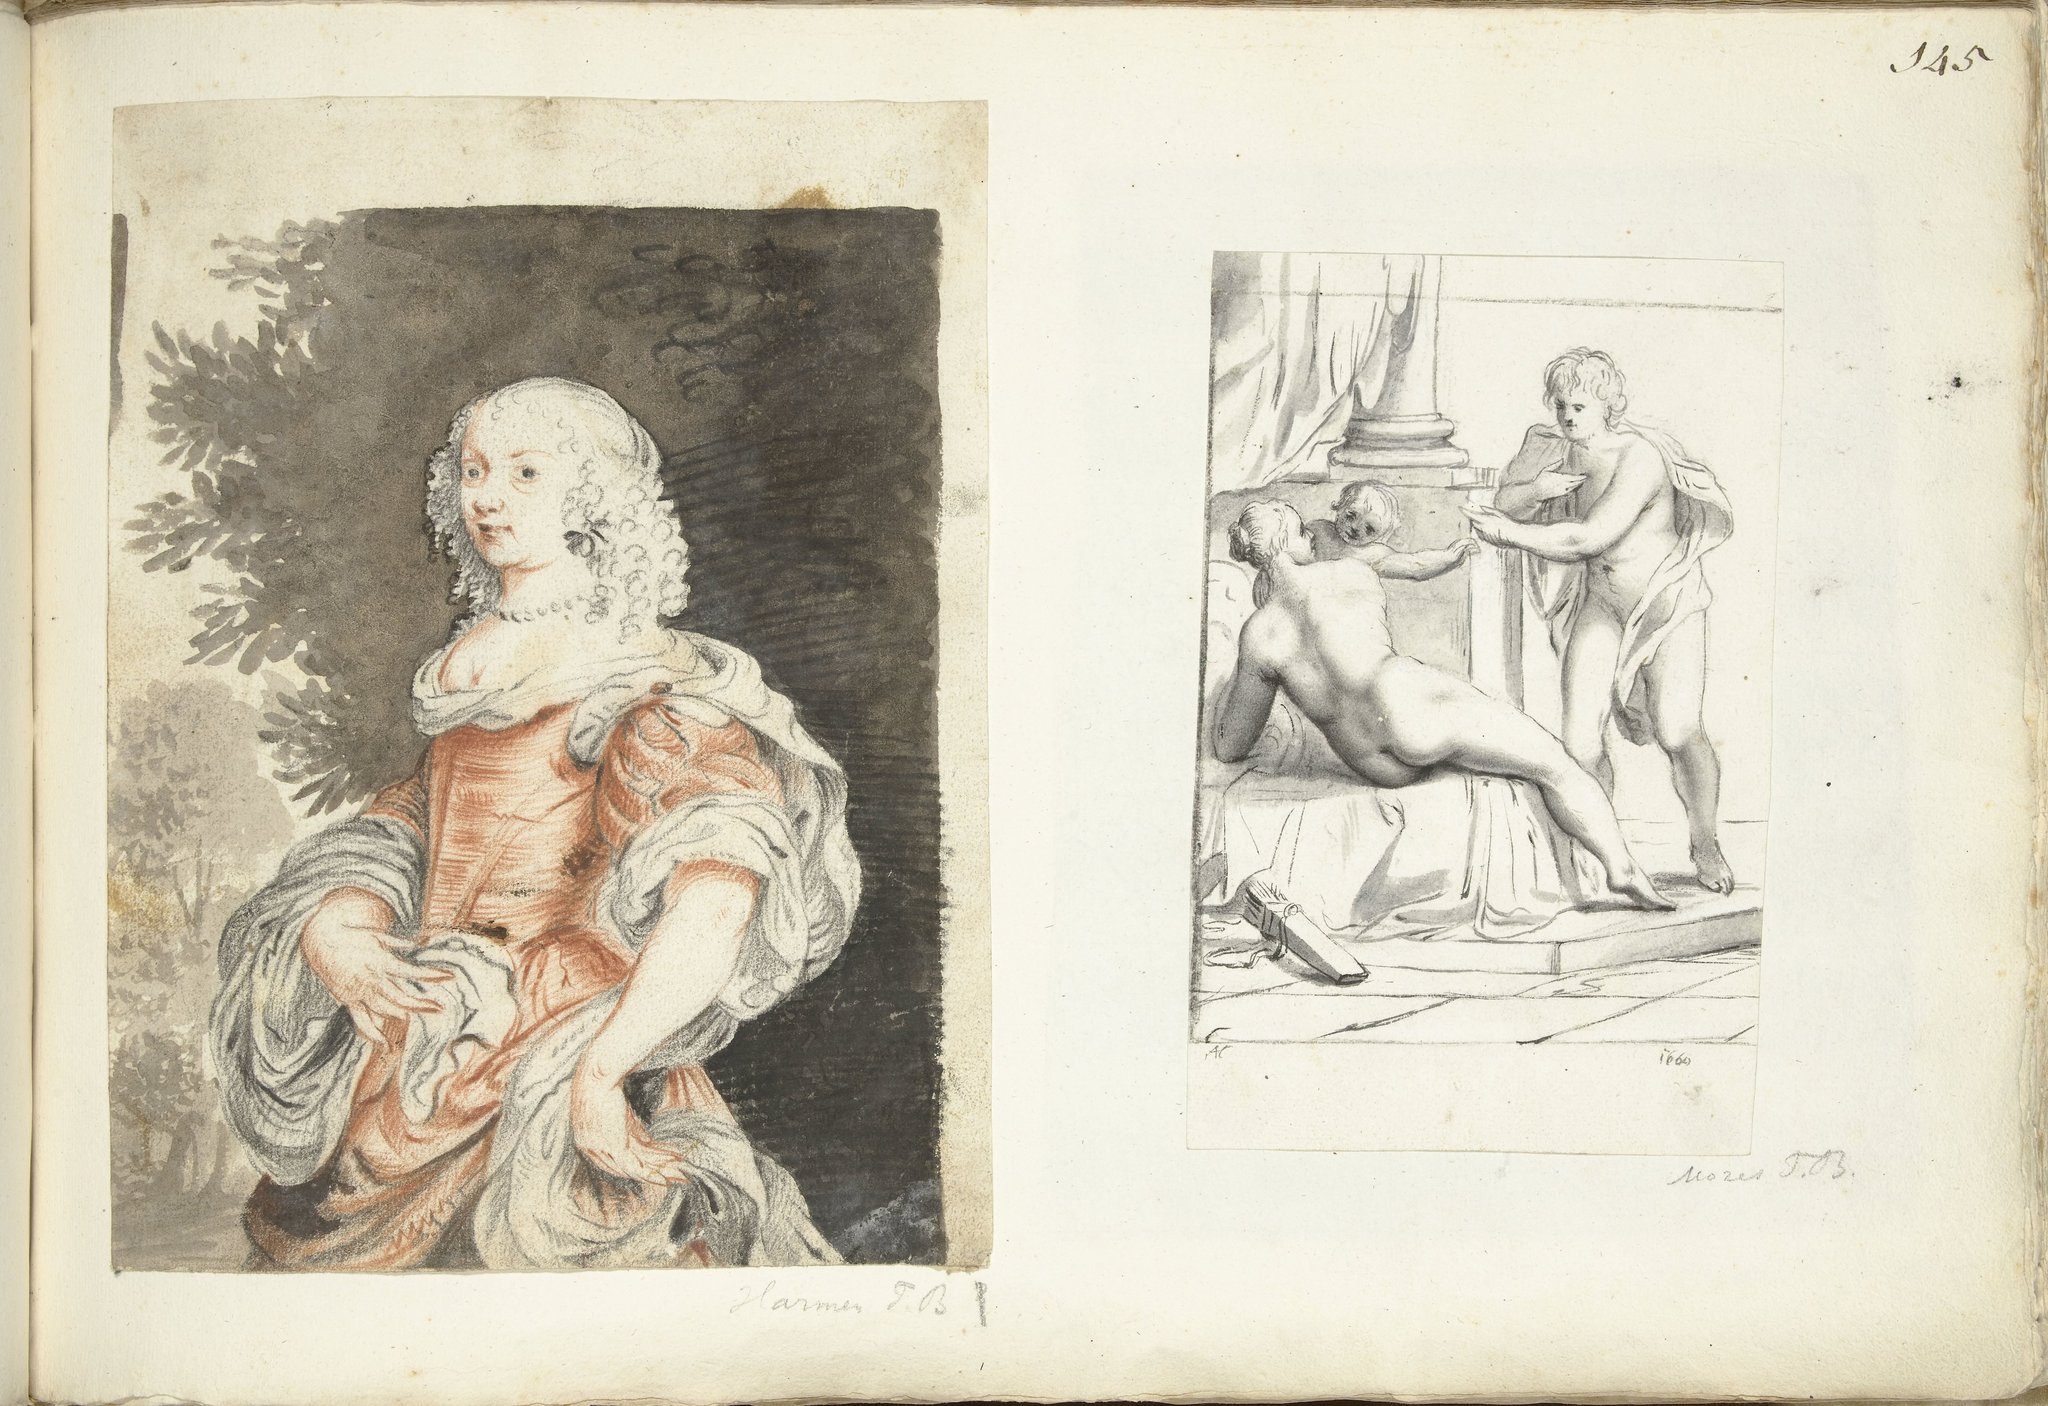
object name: drawing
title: Portret van een vrouw en Venus, Amor en Mars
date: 1660-1687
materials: chalk, ink, paper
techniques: brush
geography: zwolle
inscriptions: annotation: ‘Harmen T.B? [vraagteken doorgestreept] / Mozes T.B.’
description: Twee tekeningen naast elkaar op een blad geplakt.